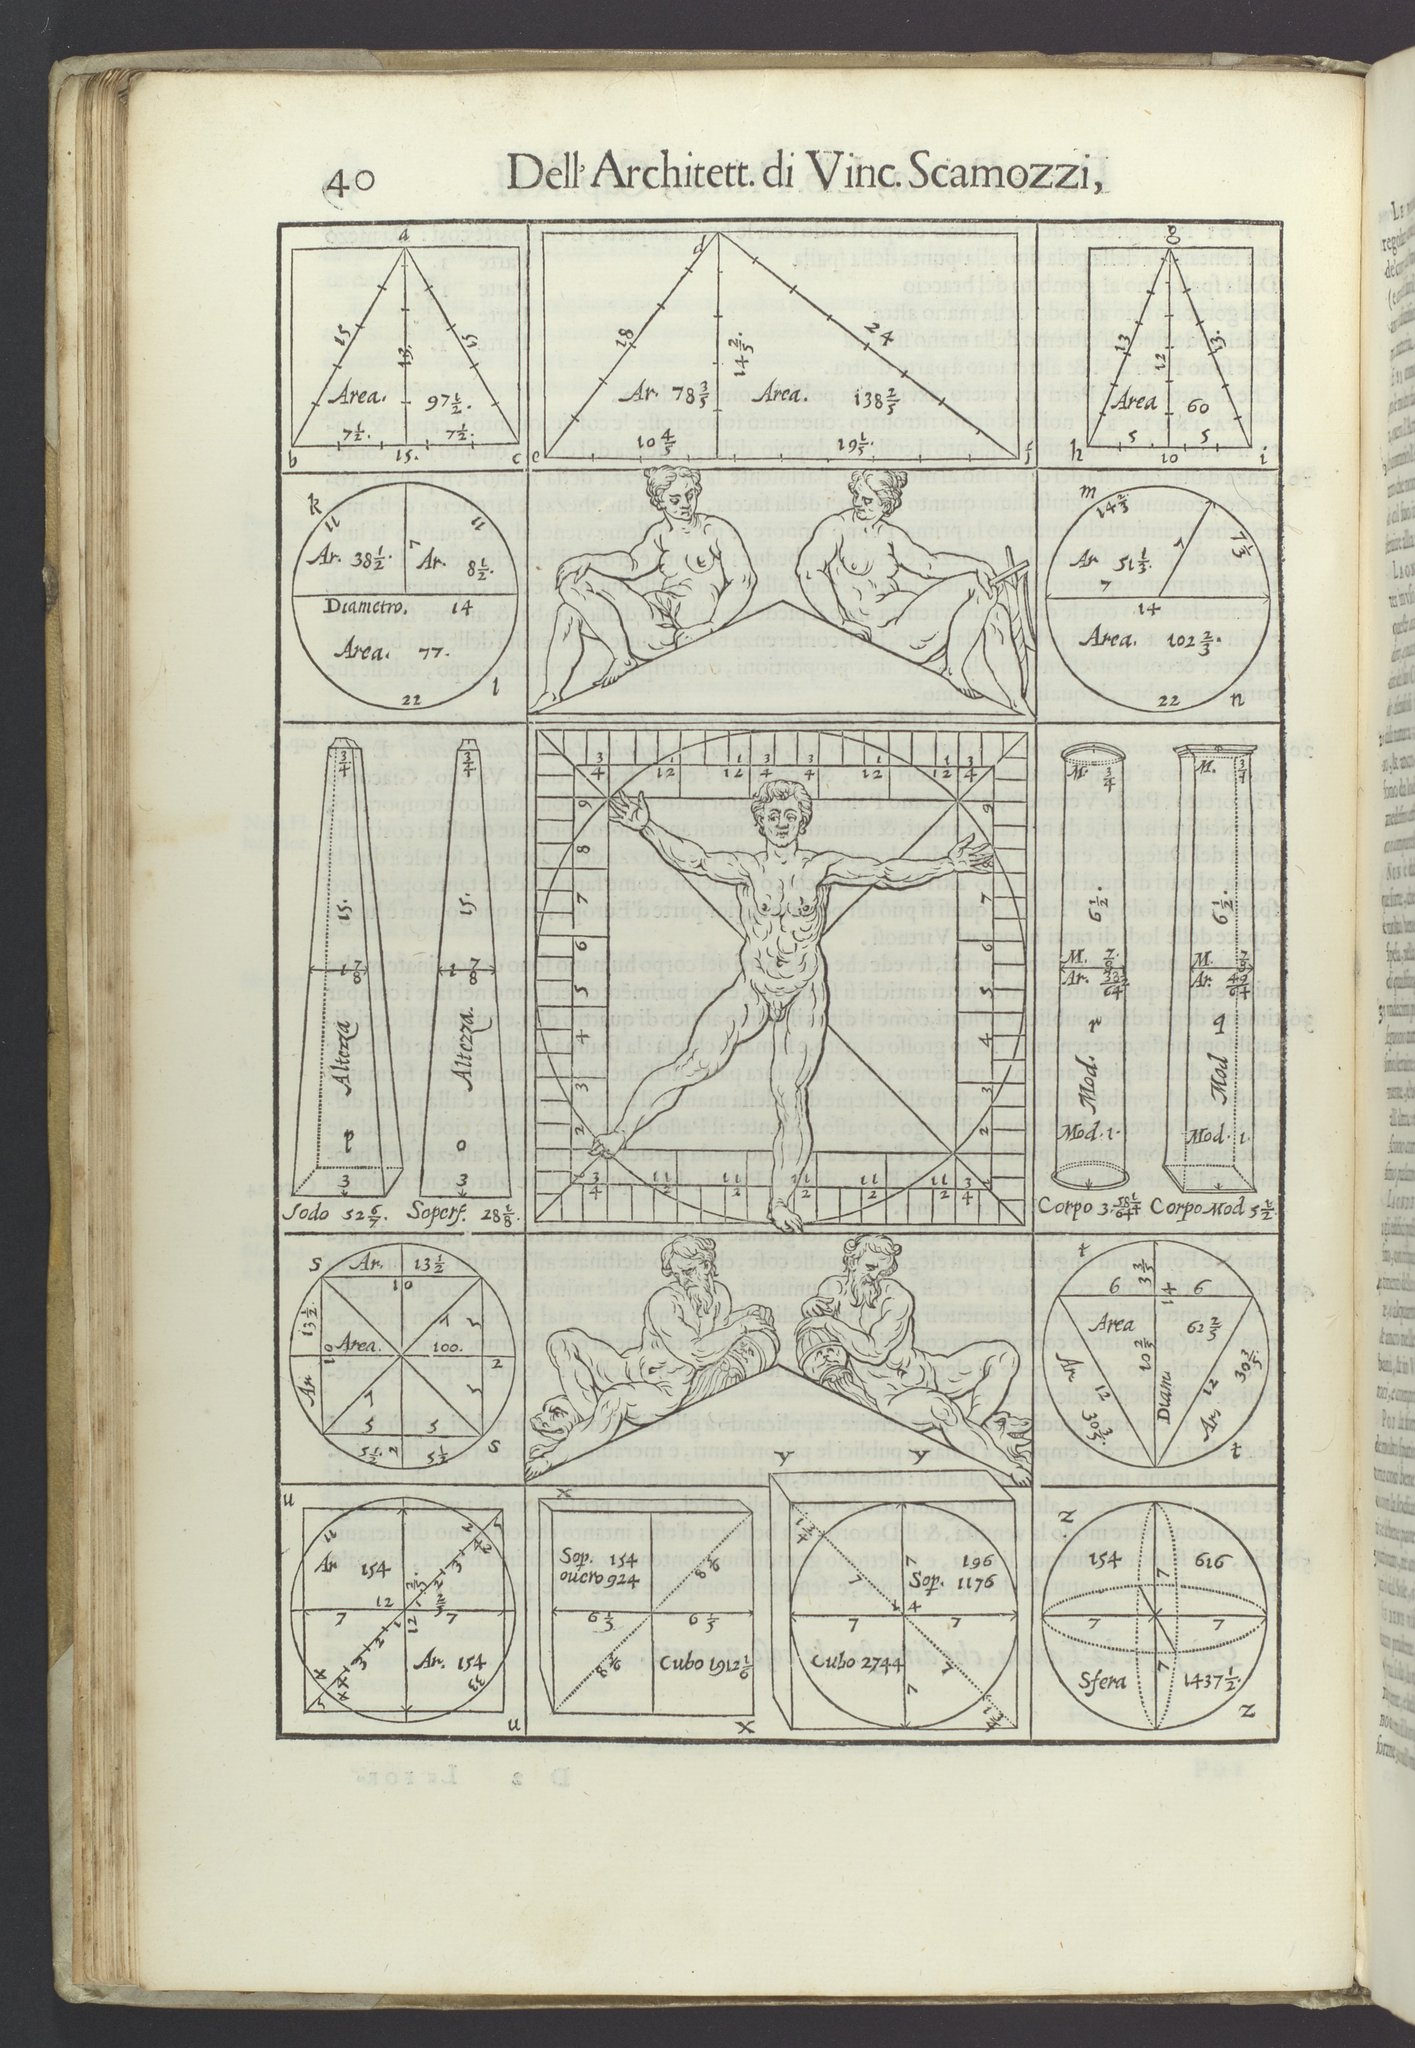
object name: book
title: Diagrams of proportion and the human body, from "L'Idea della Architettura"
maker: vincenzo scamozzi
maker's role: author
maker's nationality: italian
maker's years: 1548-1616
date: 1615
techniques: woodcut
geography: italy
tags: architecture